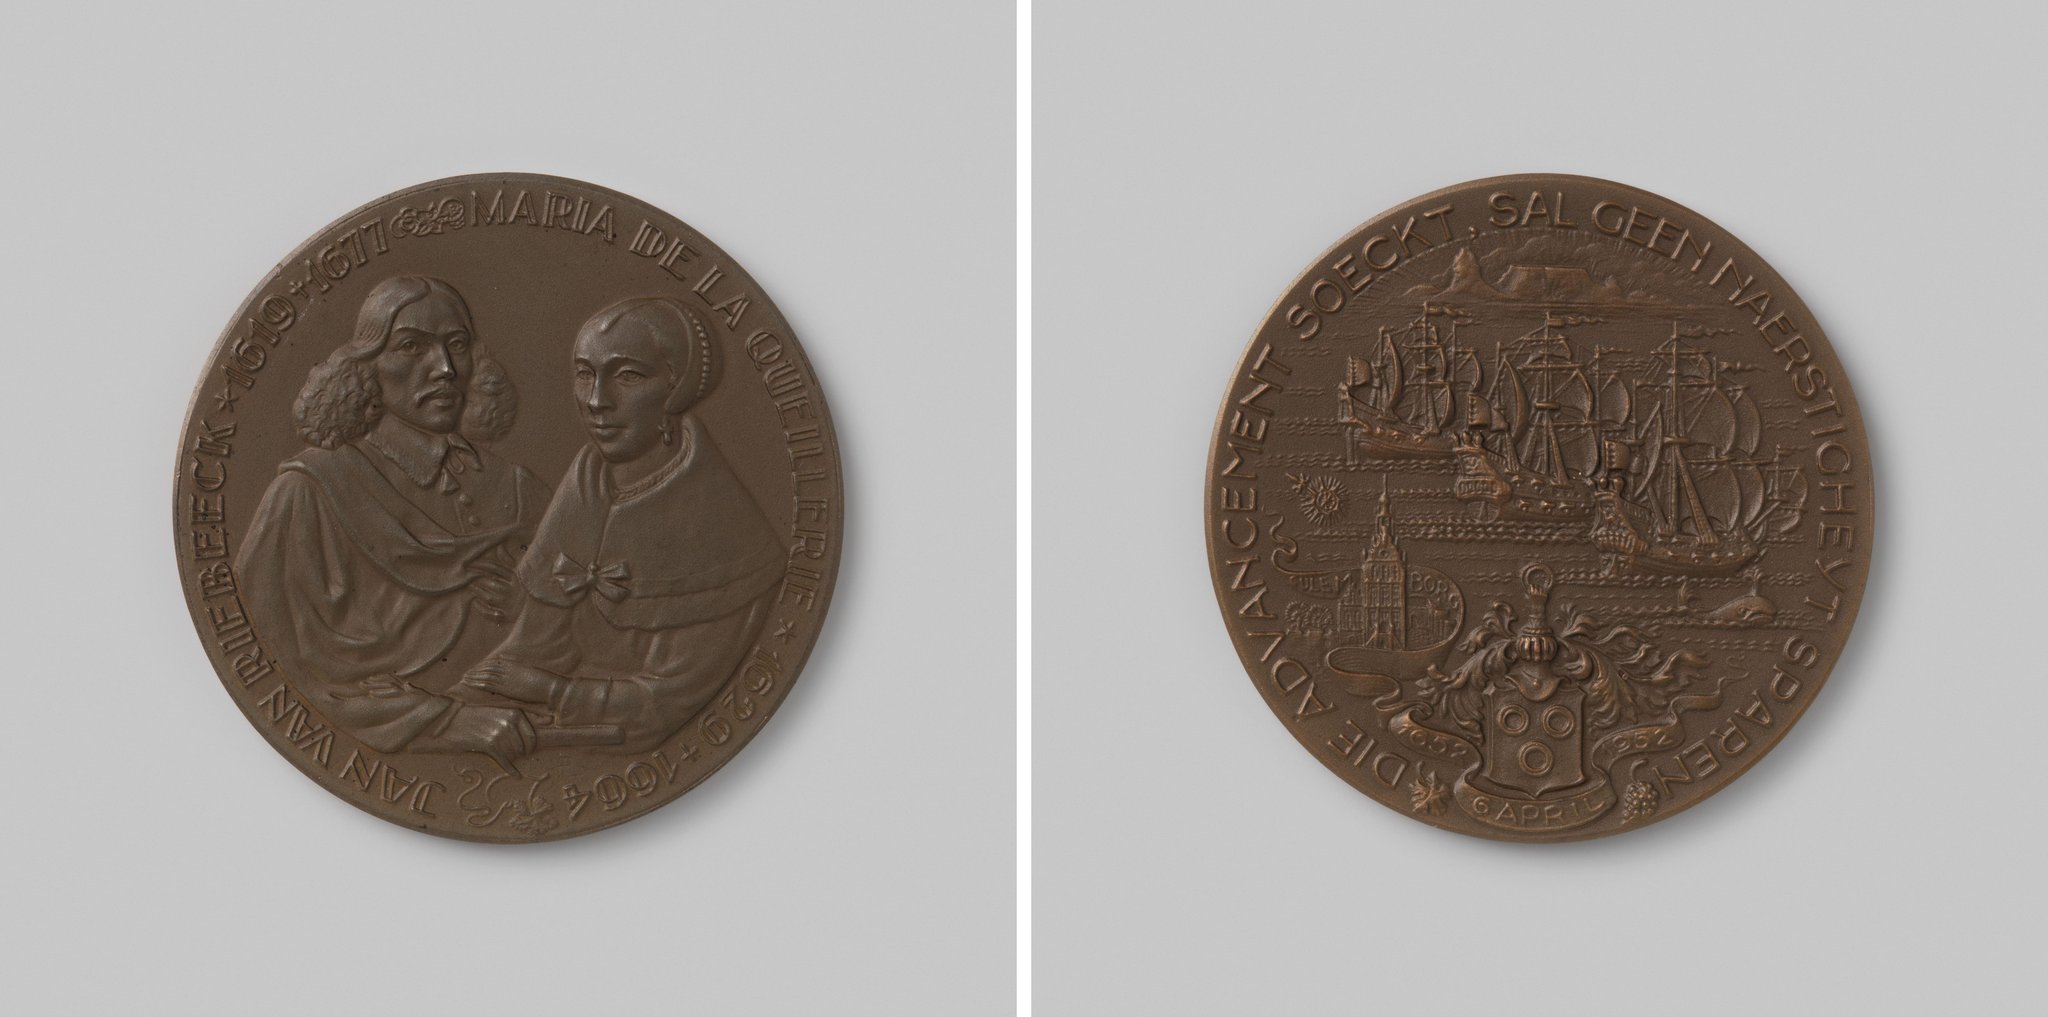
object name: history medal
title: Jan van Riebeeck 1652 - 1952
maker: maarten pauw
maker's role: designer, sculptor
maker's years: 1912-1966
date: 1952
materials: bronze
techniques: striking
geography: voorschoten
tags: batavia, rotterdam, cape of good hope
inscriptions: date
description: De drie schepen waarmee van Riebeeck landde: 'Dromedaris', 'Reyger' en 'de Hope'.